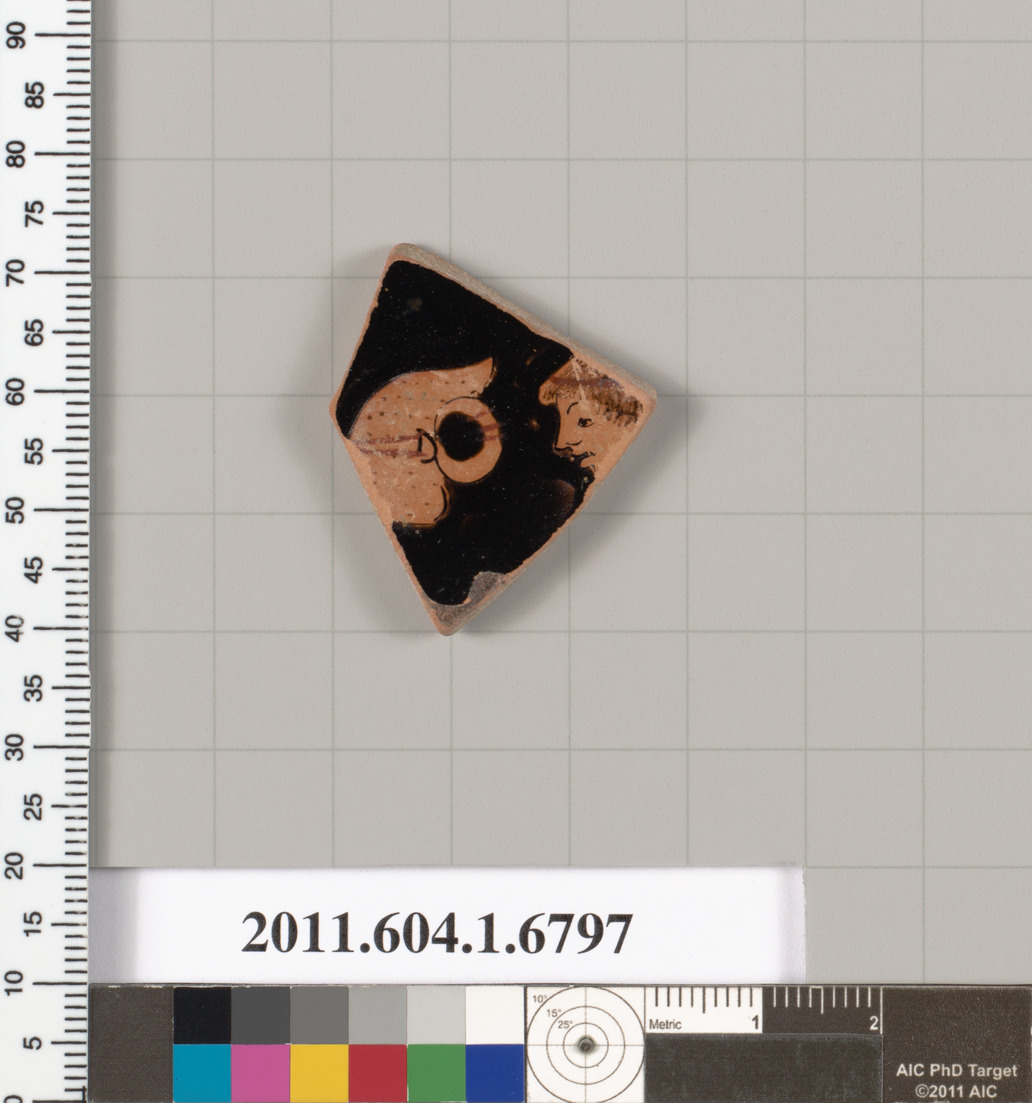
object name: kylix fragment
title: Terracotta fragment of a kylix (drinking cup)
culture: greek, attic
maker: brygos painter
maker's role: artist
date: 490-470 BCE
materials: terracotta